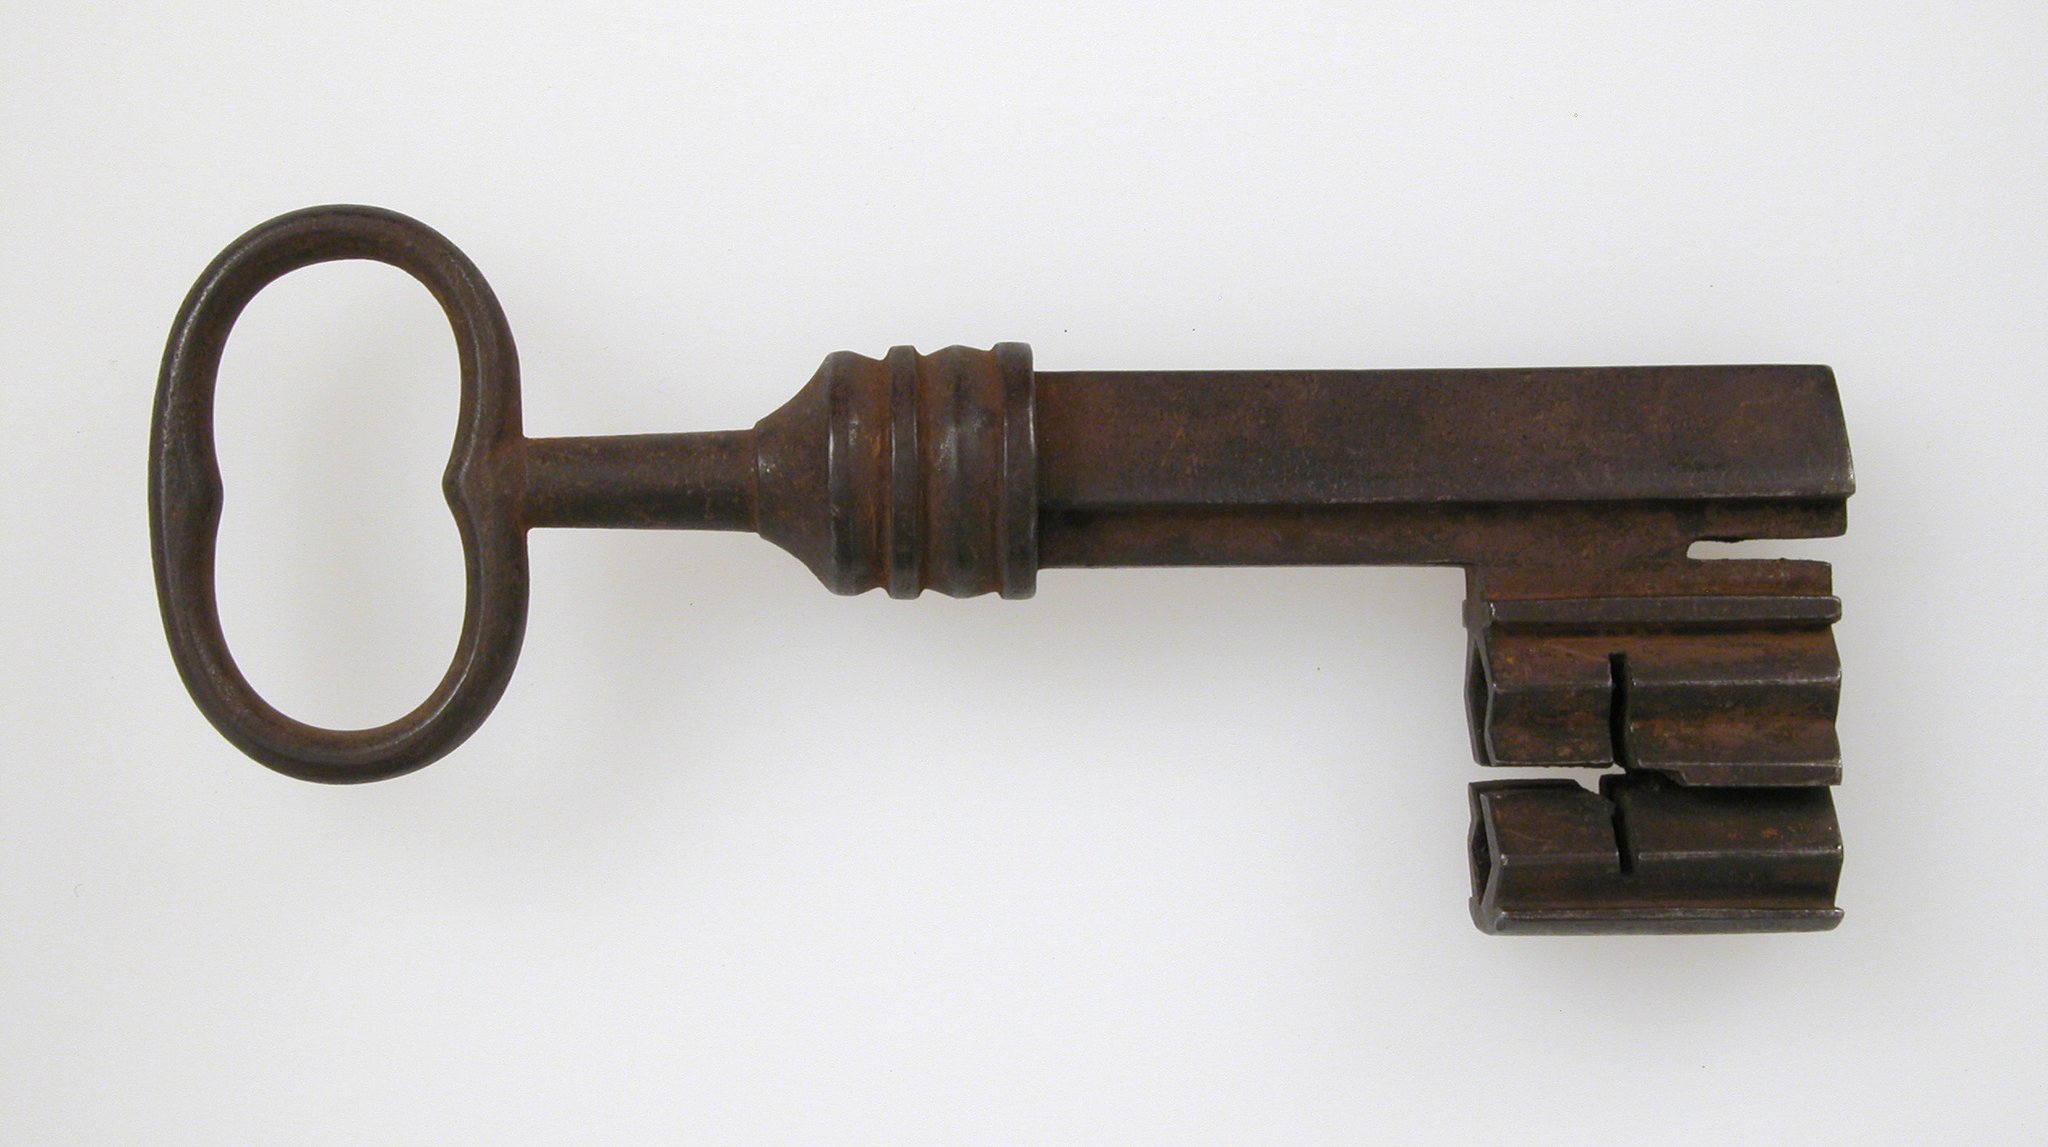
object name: key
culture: german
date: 1401-1600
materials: iron